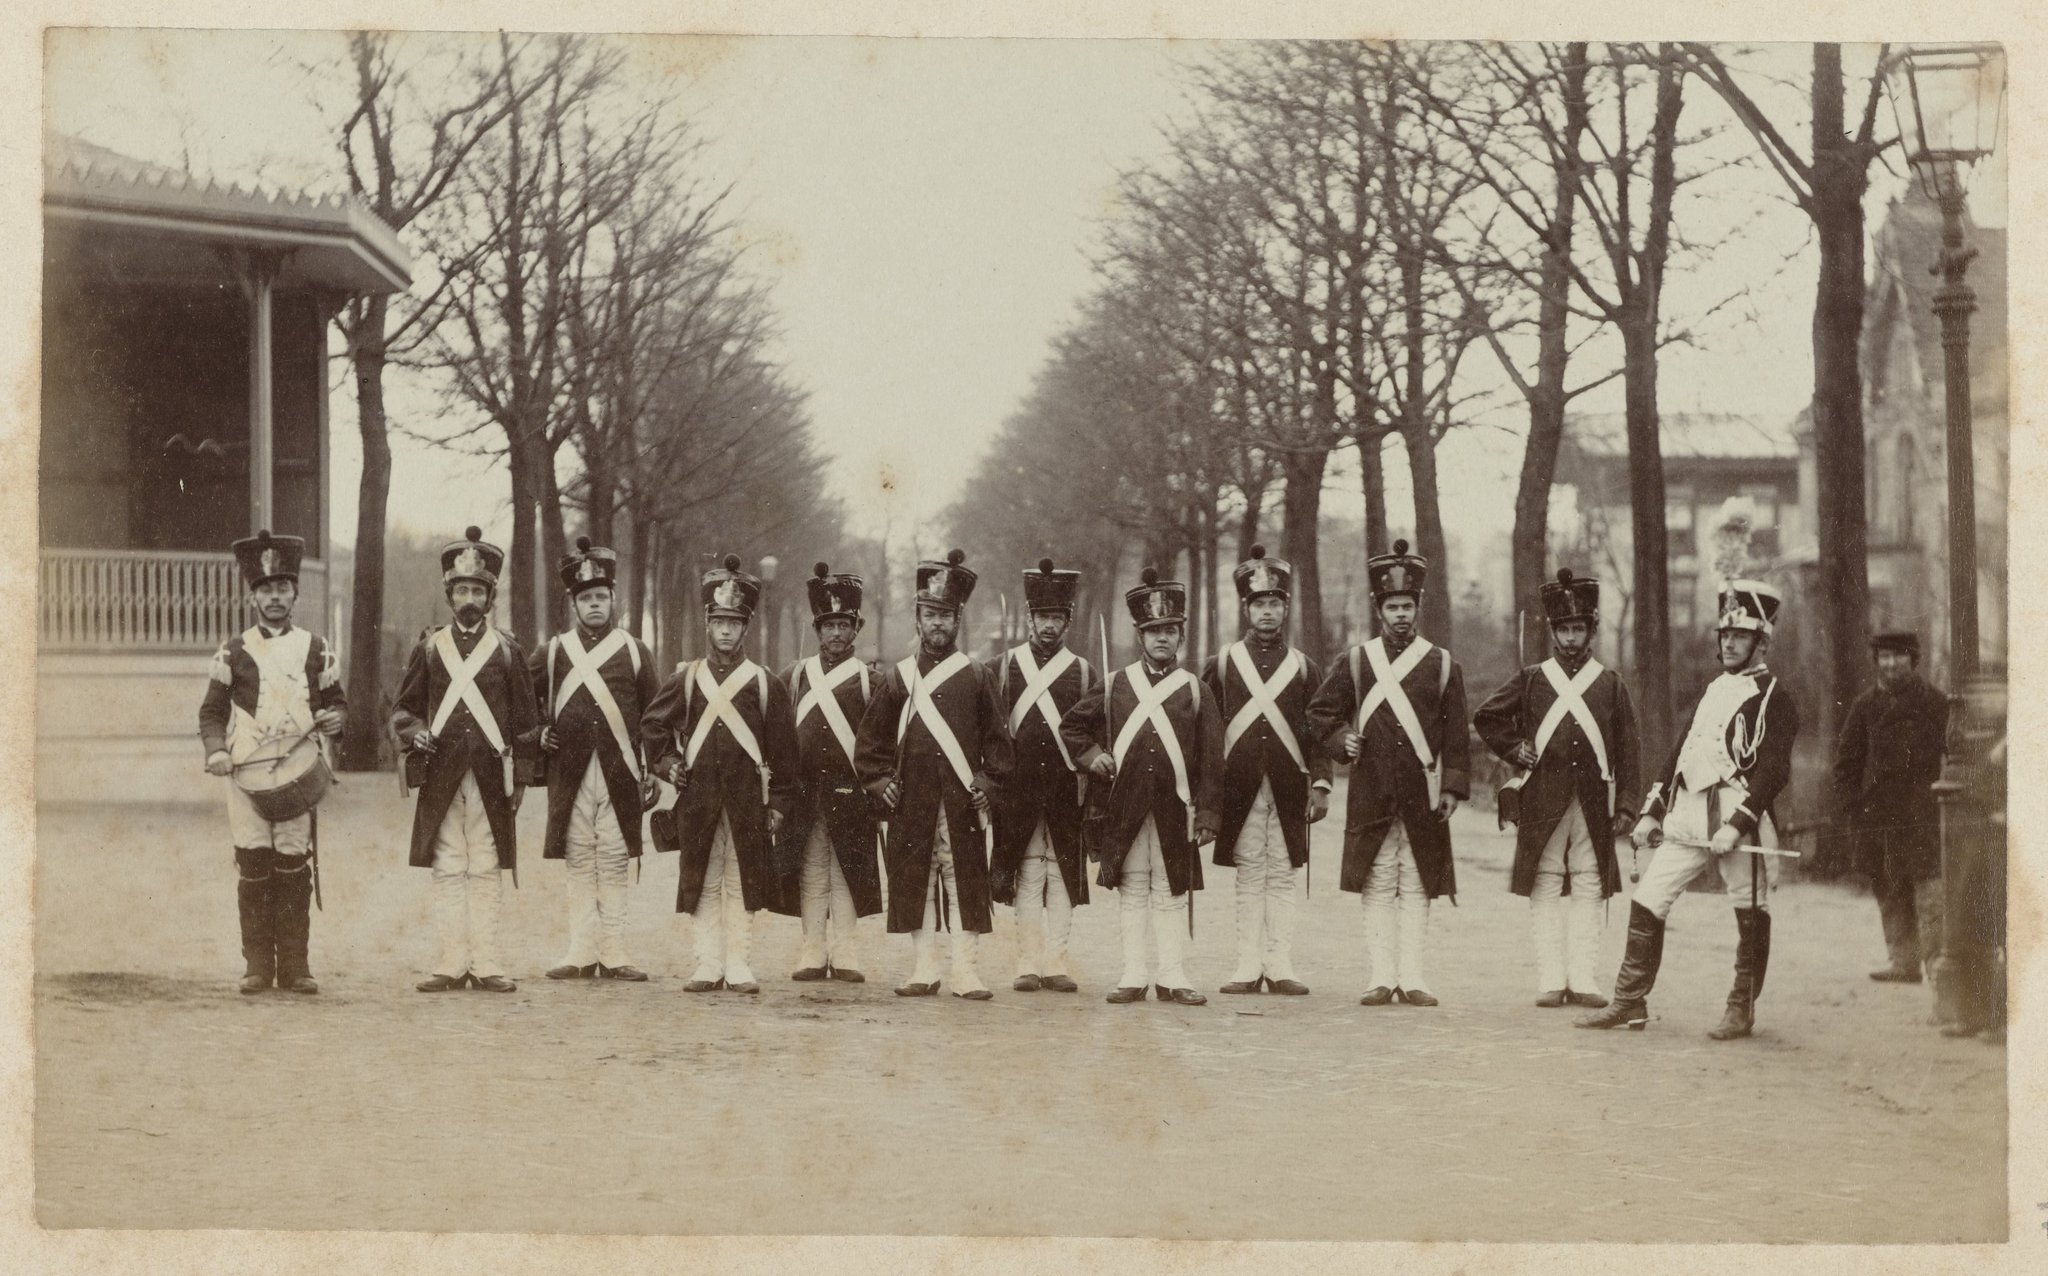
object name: photograph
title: Mannen in historische militaire uniformen ter gelegenheid van de onafhankelijkheidsfeesten in Dordrecht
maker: Anonymous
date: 1888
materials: cardboard, paper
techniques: albumen print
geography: dordrecht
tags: public festivities, (military) uniforms, dordrecht